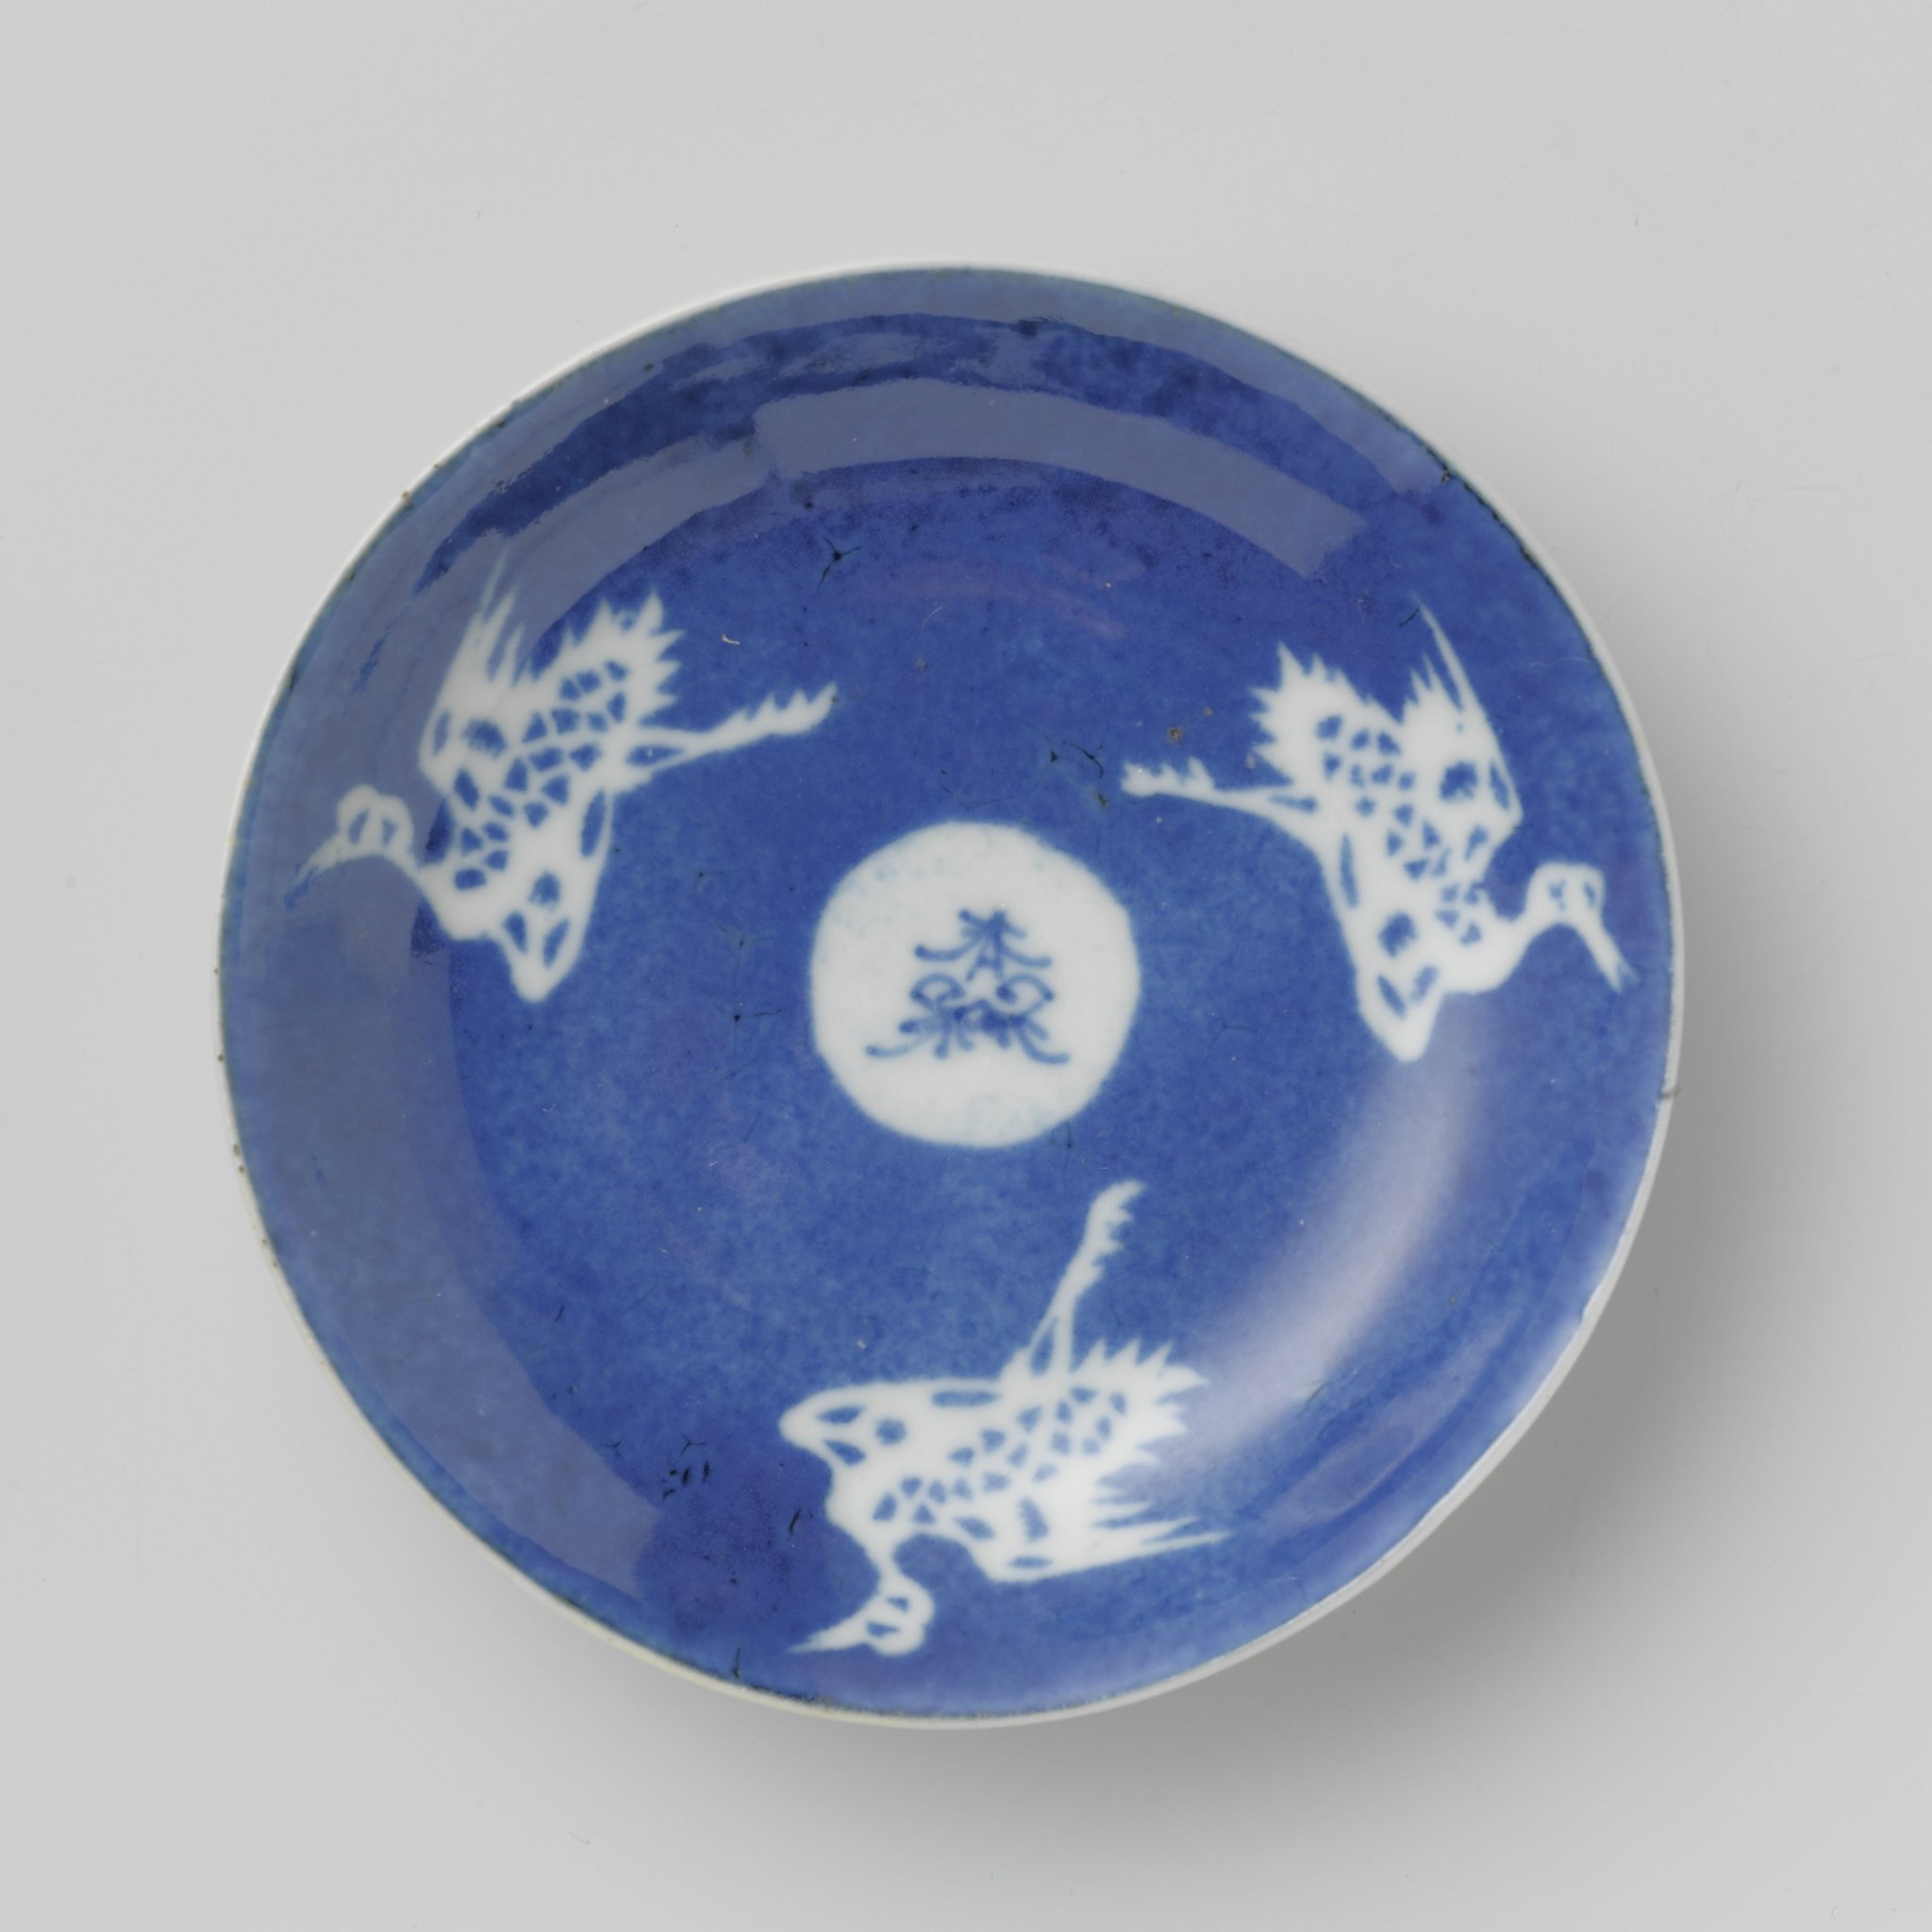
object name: platter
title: Saucer with powder blue and cranes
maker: Anonymous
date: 1700-1724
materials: cobalt, glaze, paint, porcelain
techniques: firing, turning, vitrification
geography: china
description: Schotel van porselein, beschilderd in onderglazuur blauw. Met bijbehorende theekop (AK-RBK-15855-A-1). Bleu poudré.